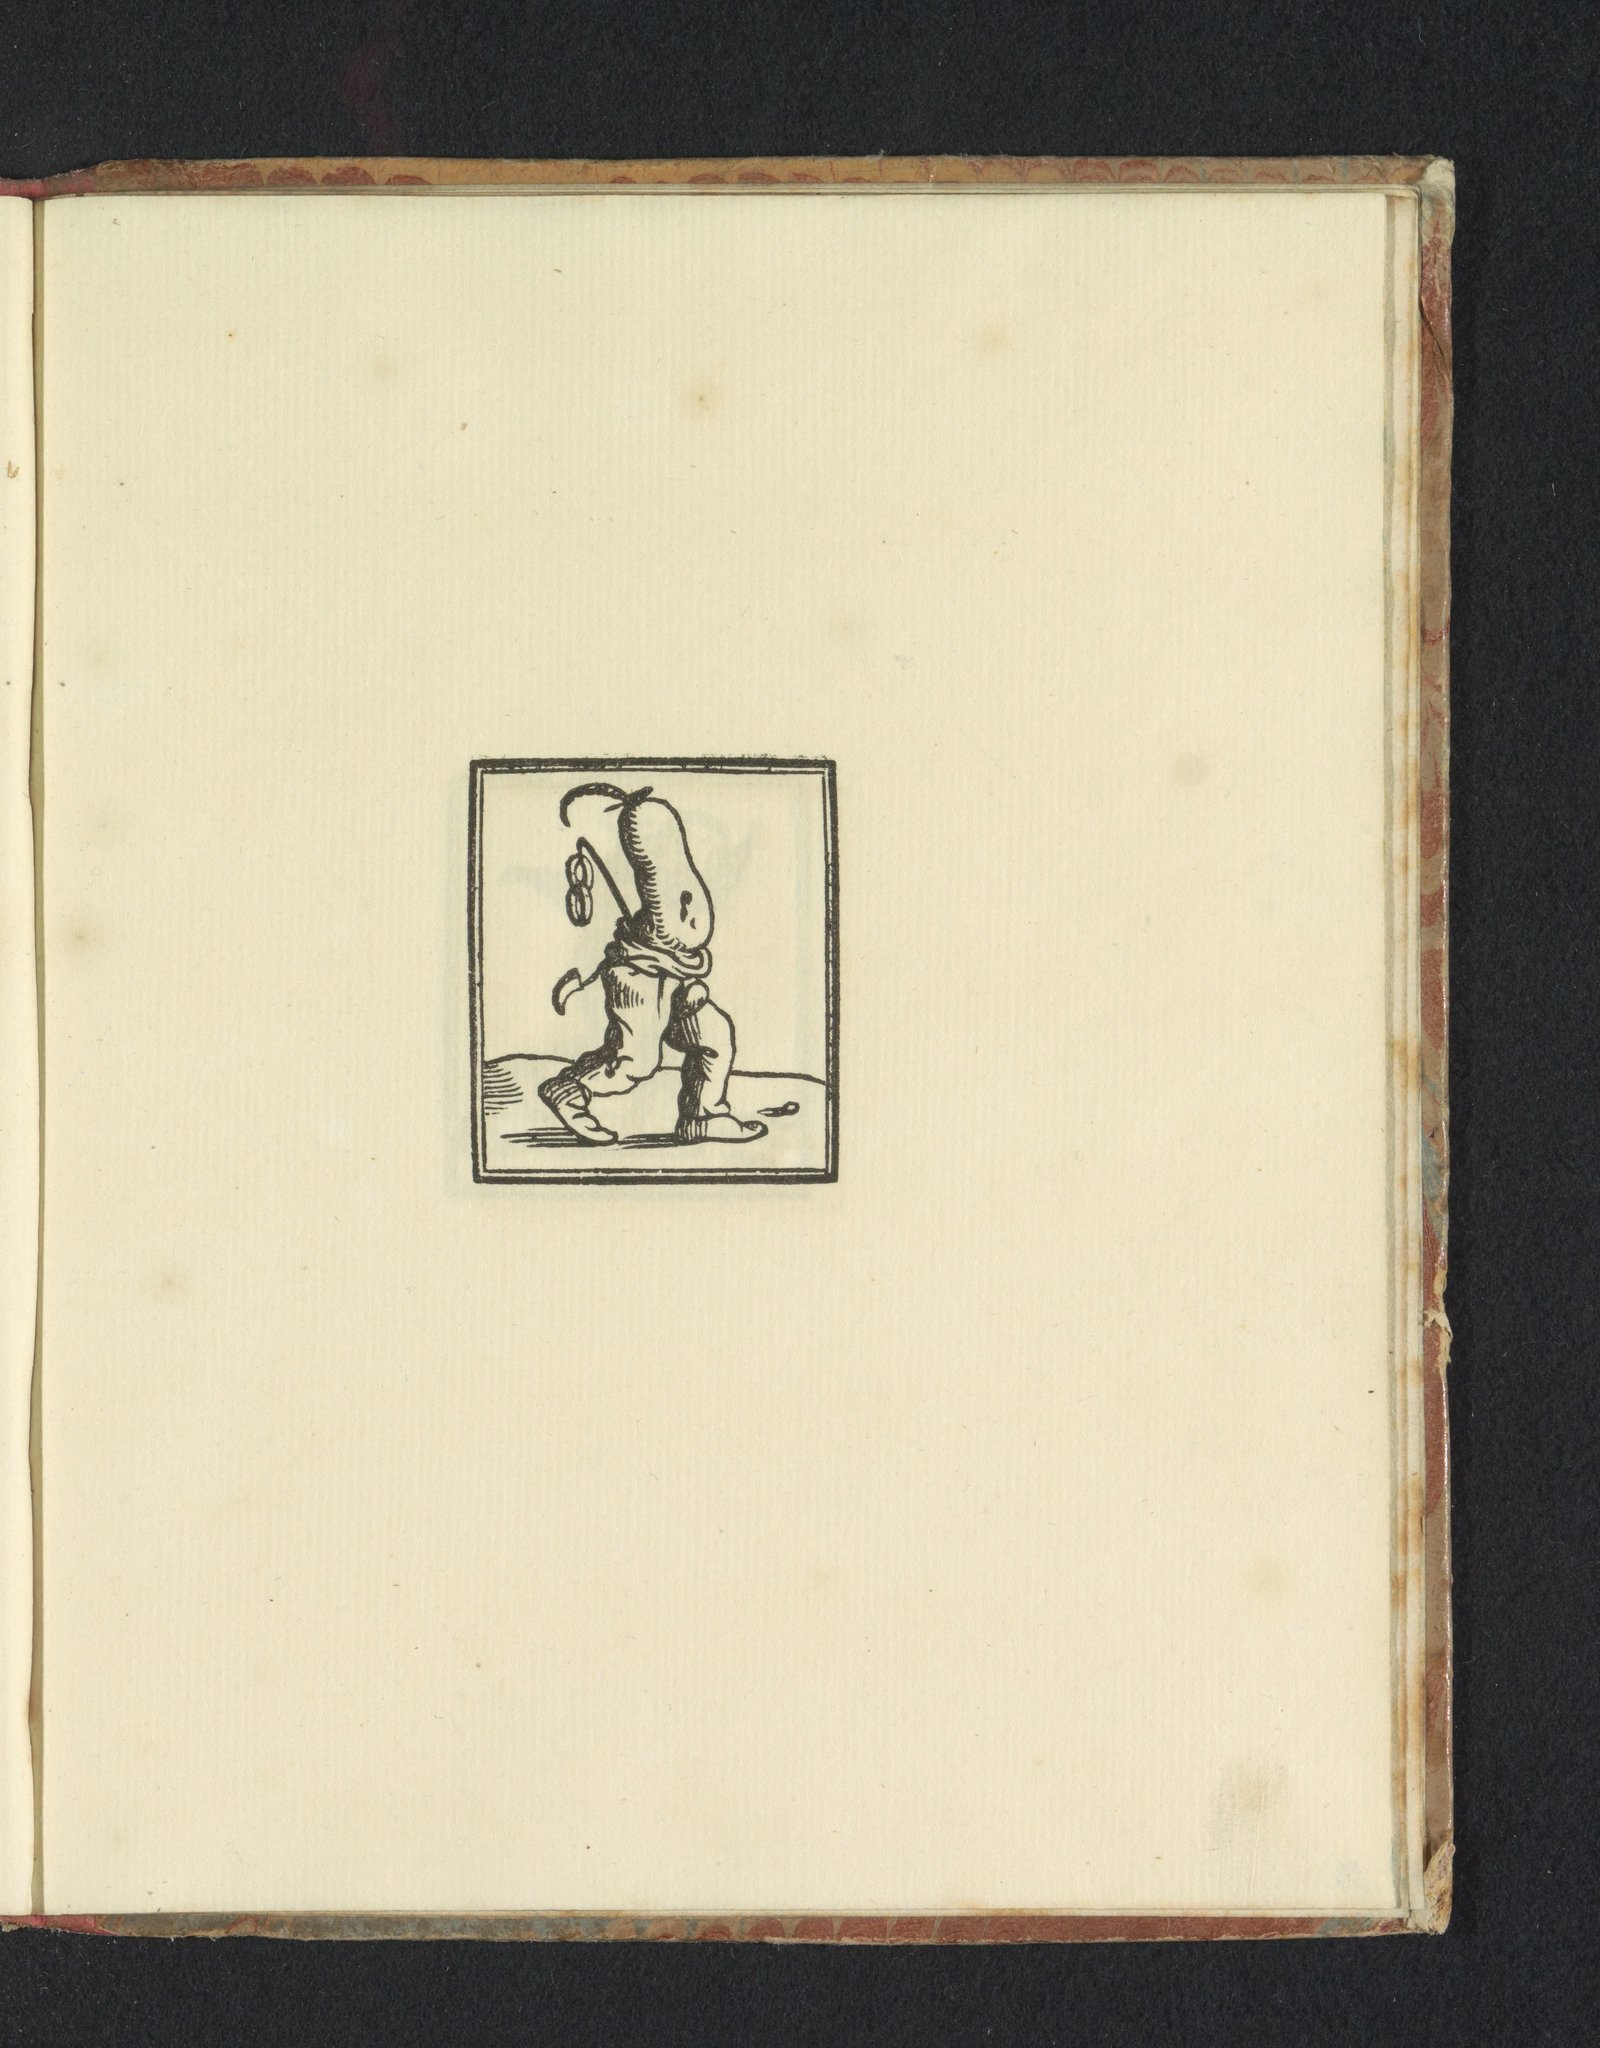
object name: print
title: Bloed-beuling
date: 1731-1732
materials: paper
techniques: woodcut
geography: haarlem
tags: caricatures (human types)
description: Koddige figuur, in het onderschrift in de overzichtsprent draagt deze figuur de naam: Bloed-beuling. Onderdeel van het boekje: XXXVI. aartige figuuren, geinventeert door Izaak van Ostade tot Haarlem [1731-1732].